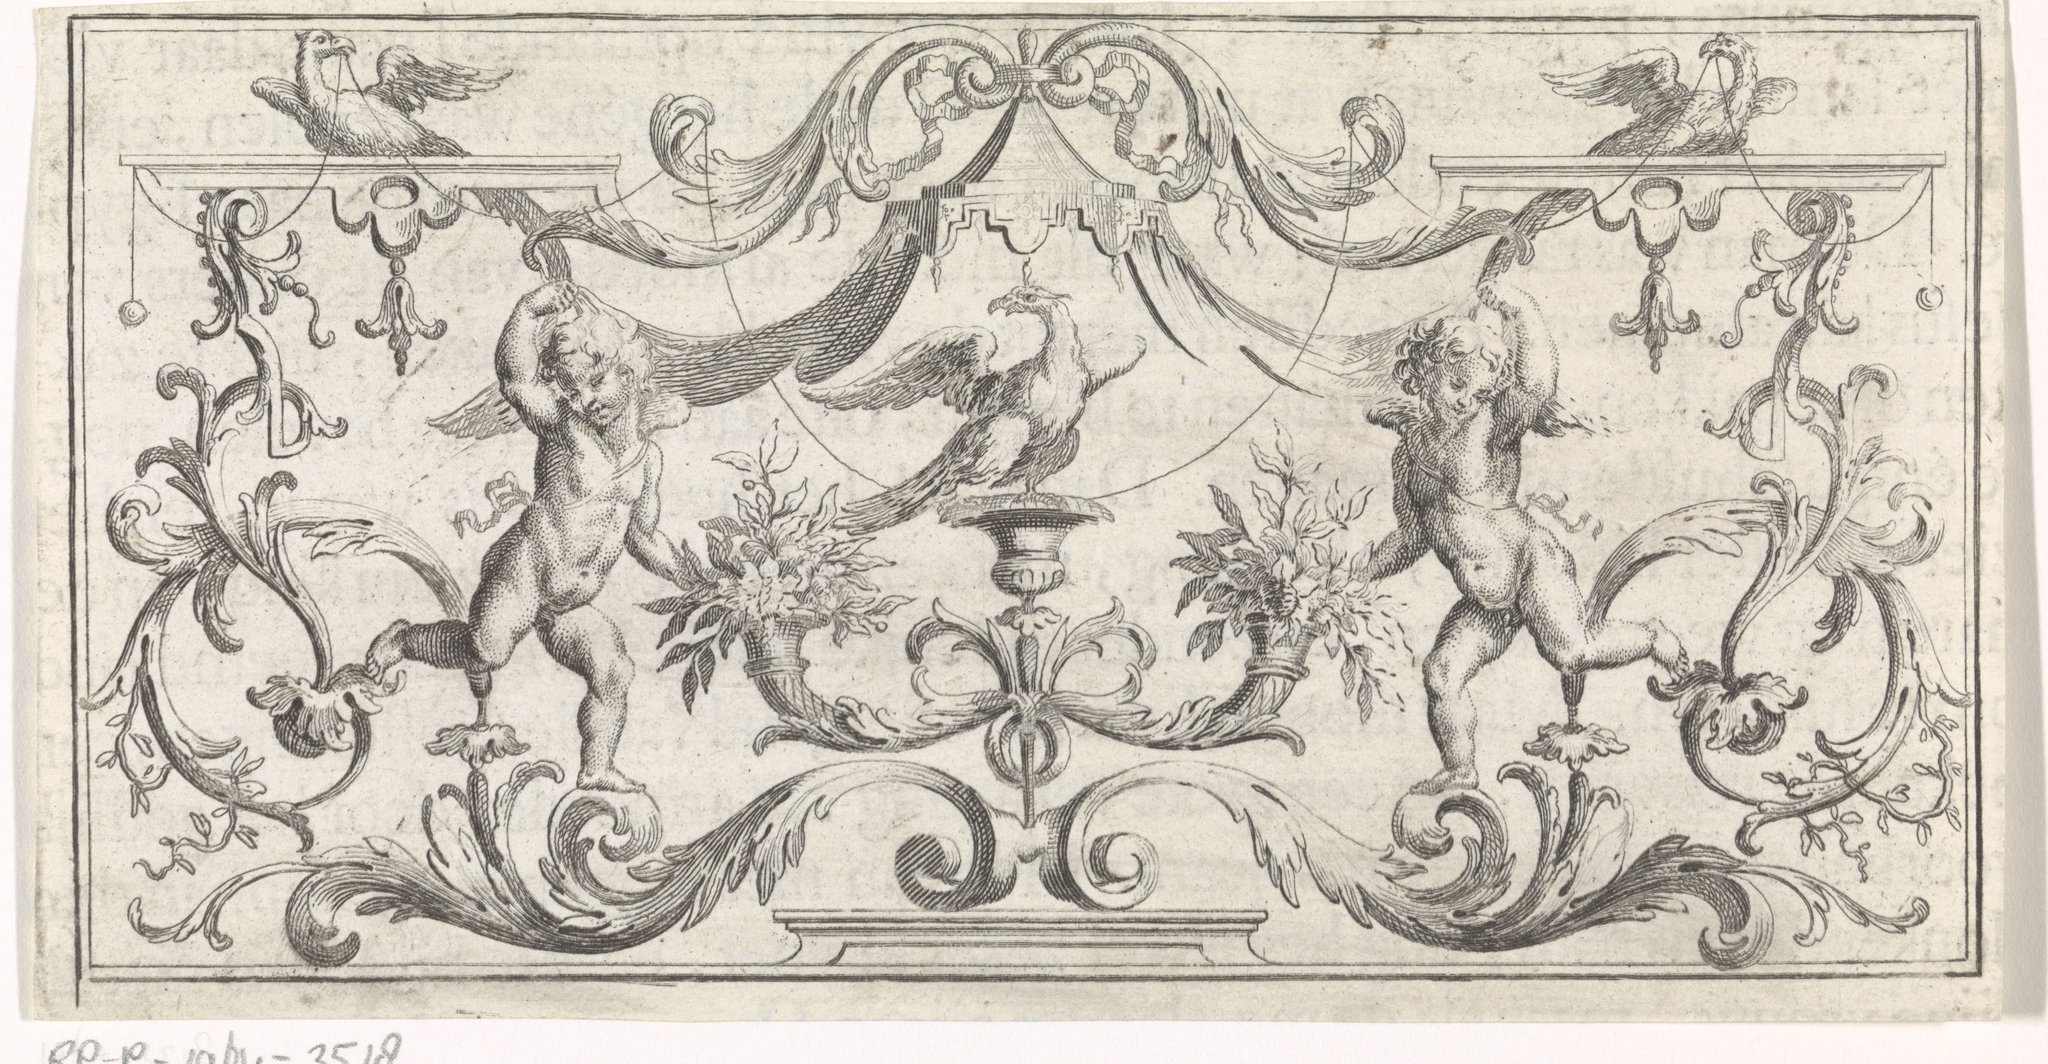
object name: book illustration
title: Ornament met een adelaar onder een baldakijn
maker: bernard picart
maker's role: draughtsman, print maker, publisher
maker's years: 1673-1733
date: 1683-1733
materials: paper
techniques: engraving, etching, letterpress printing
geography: amsterdam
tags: ornament ~ festoon, garland, foliage, tendrils, branches ~ ornament, cupids: 'amores', 'amoretti', 'putti'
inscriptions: collector's mark: Lugt 2228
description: Prent oorspronkelijk bedoeld voor: Figures de la Bible. Amsterdam, Bernard Picart, 1720. Prent ook gebruikt in: Taferelen der voornaamste geschiedenissen van het Oude en Nieuwe Testament (...) door de vermaarde kunstenaars Hoet, Houbraken, en Picart getekent (...) en met beschrijvingen uitgebreid. Den Haag: Pieter de Hondt, 1728. Prent kan mogelijk ook zijn gebruikt in andere bijbels.